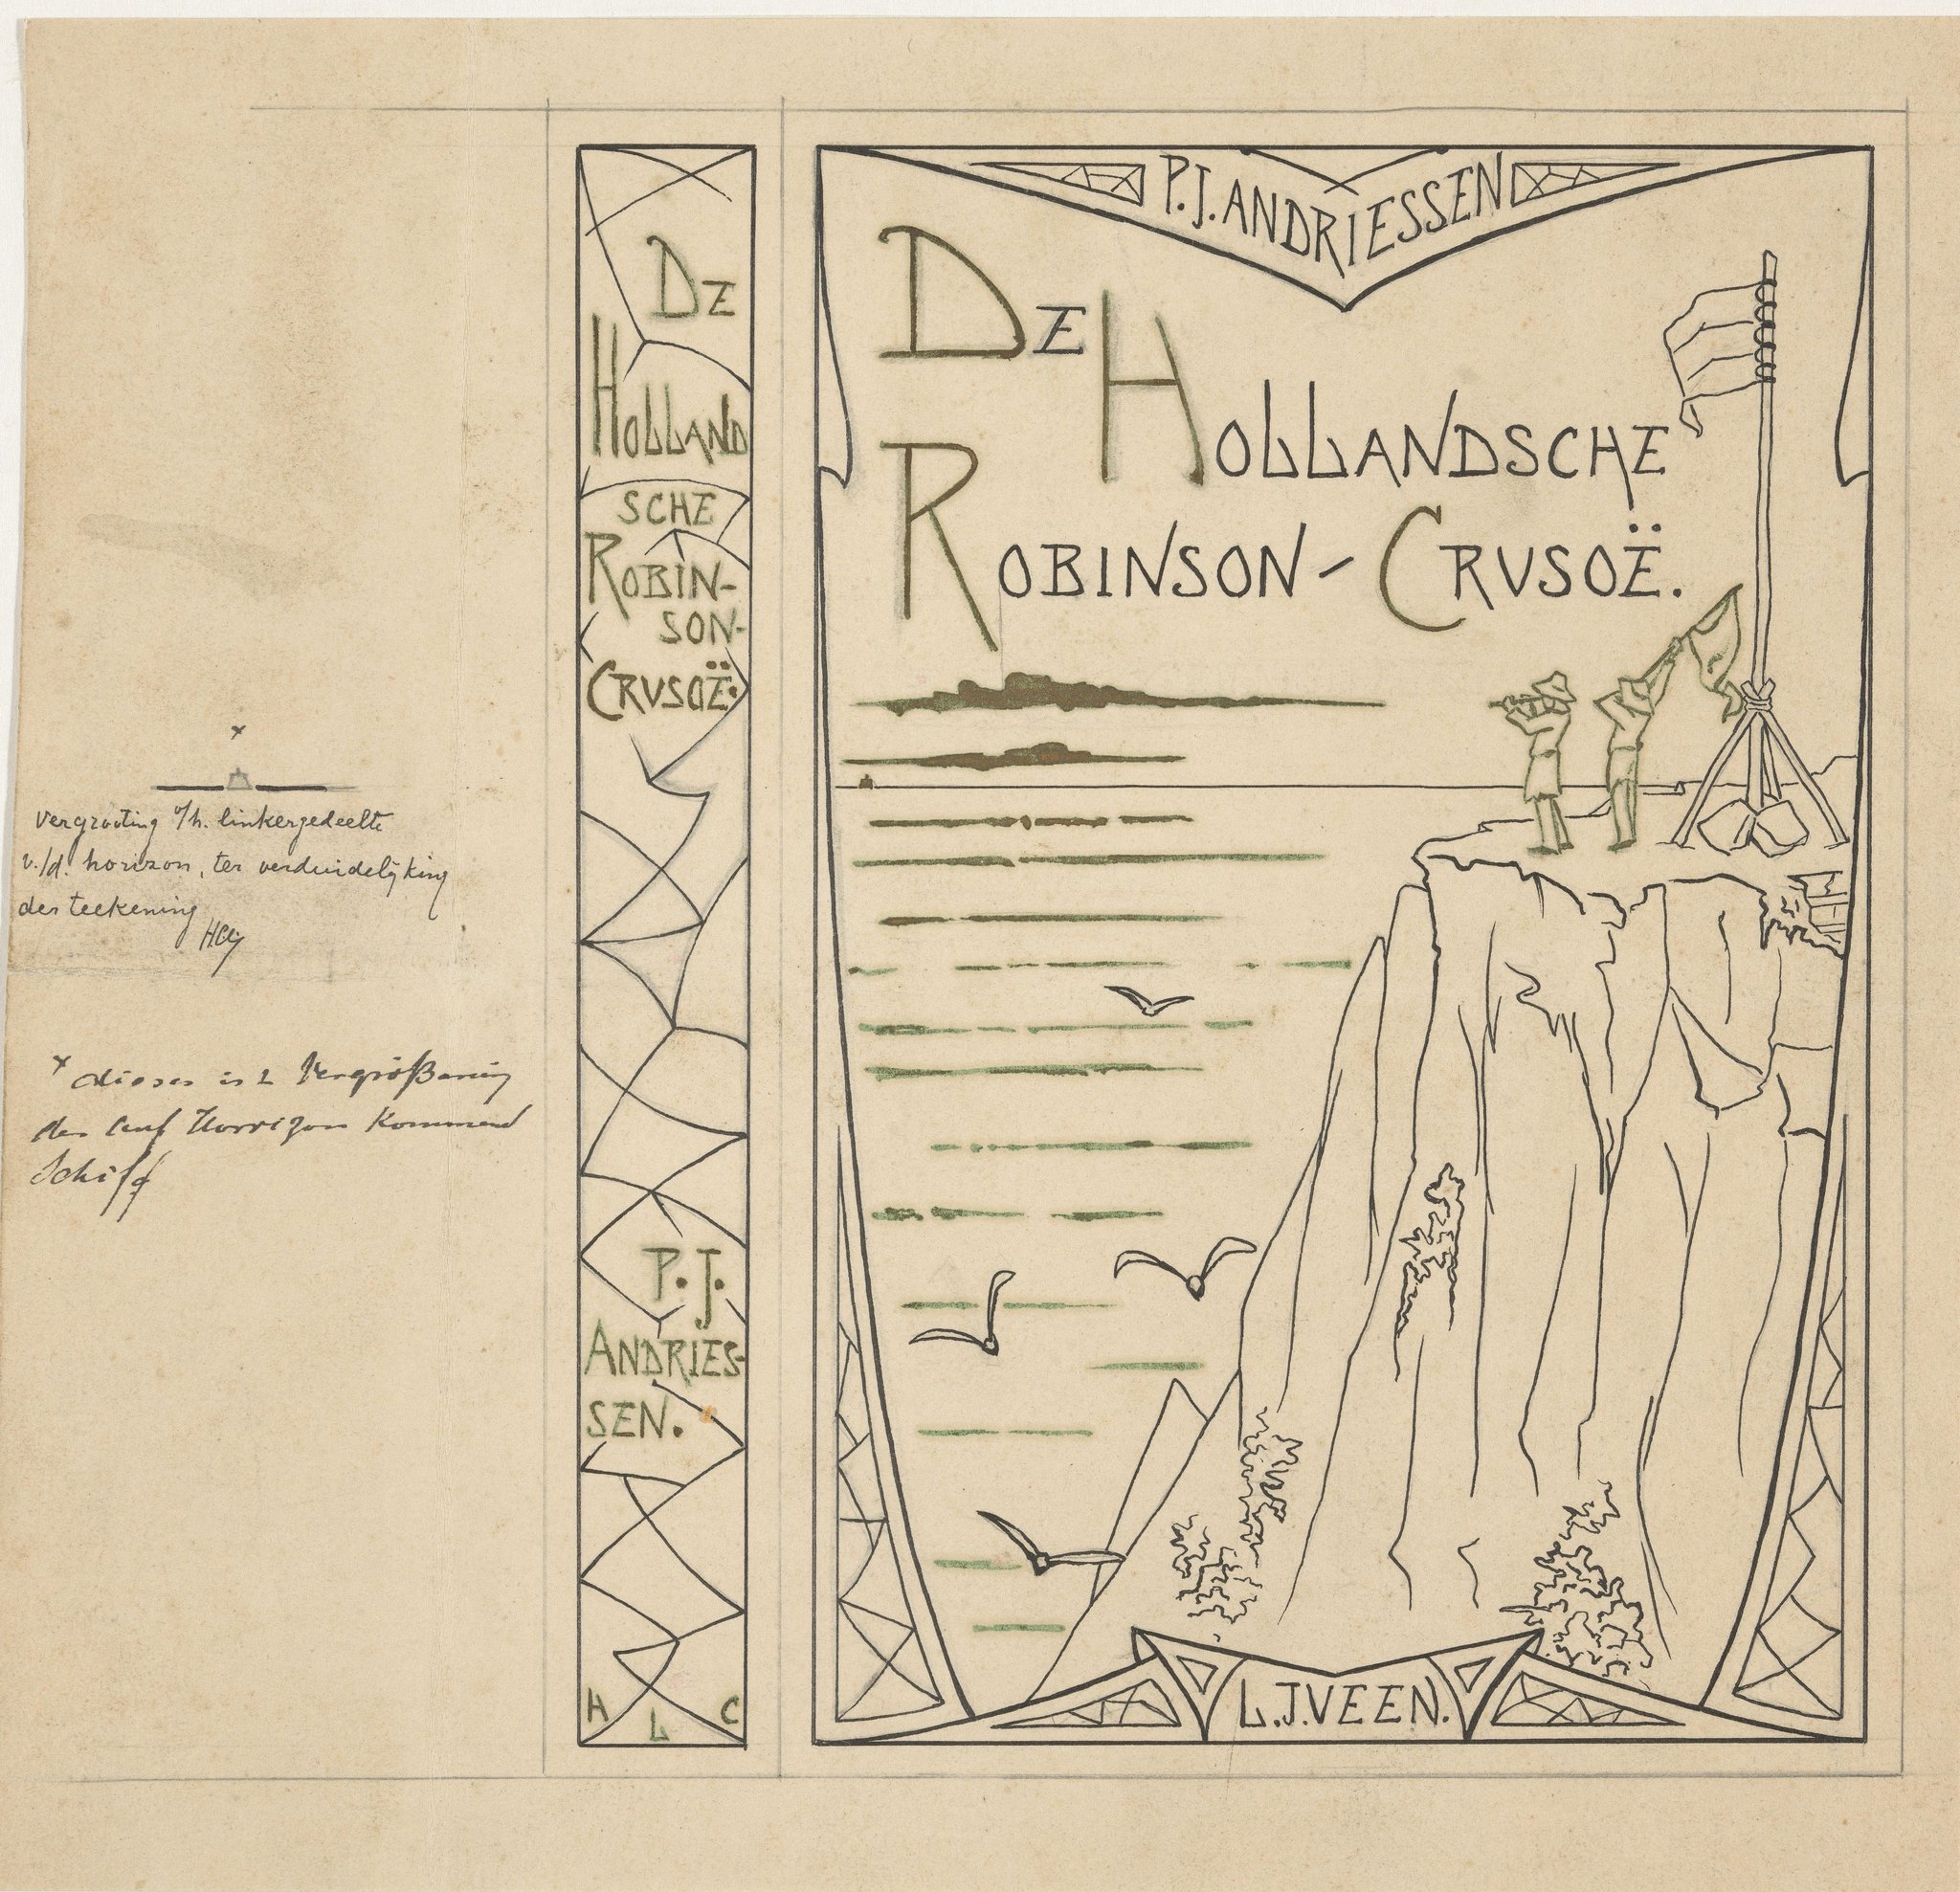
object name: drawing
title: Bandontwerp voor: P.J. Andriessen, De Hollandsche Robinson Crusoë, c. 1883-1895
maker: Anonymous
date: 1883-1895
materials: paint, ink, paper, pencil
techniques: brush, pen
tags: manual signalling with flags, coastal cliff or crag, sea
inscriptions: :, collector's mark: Lugt 2228a, signature: ‘HLC’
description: Een man met een verrekijker en een man met een vlag staan op een klif bij zee. Aan de horizon het silhouet van een schip.